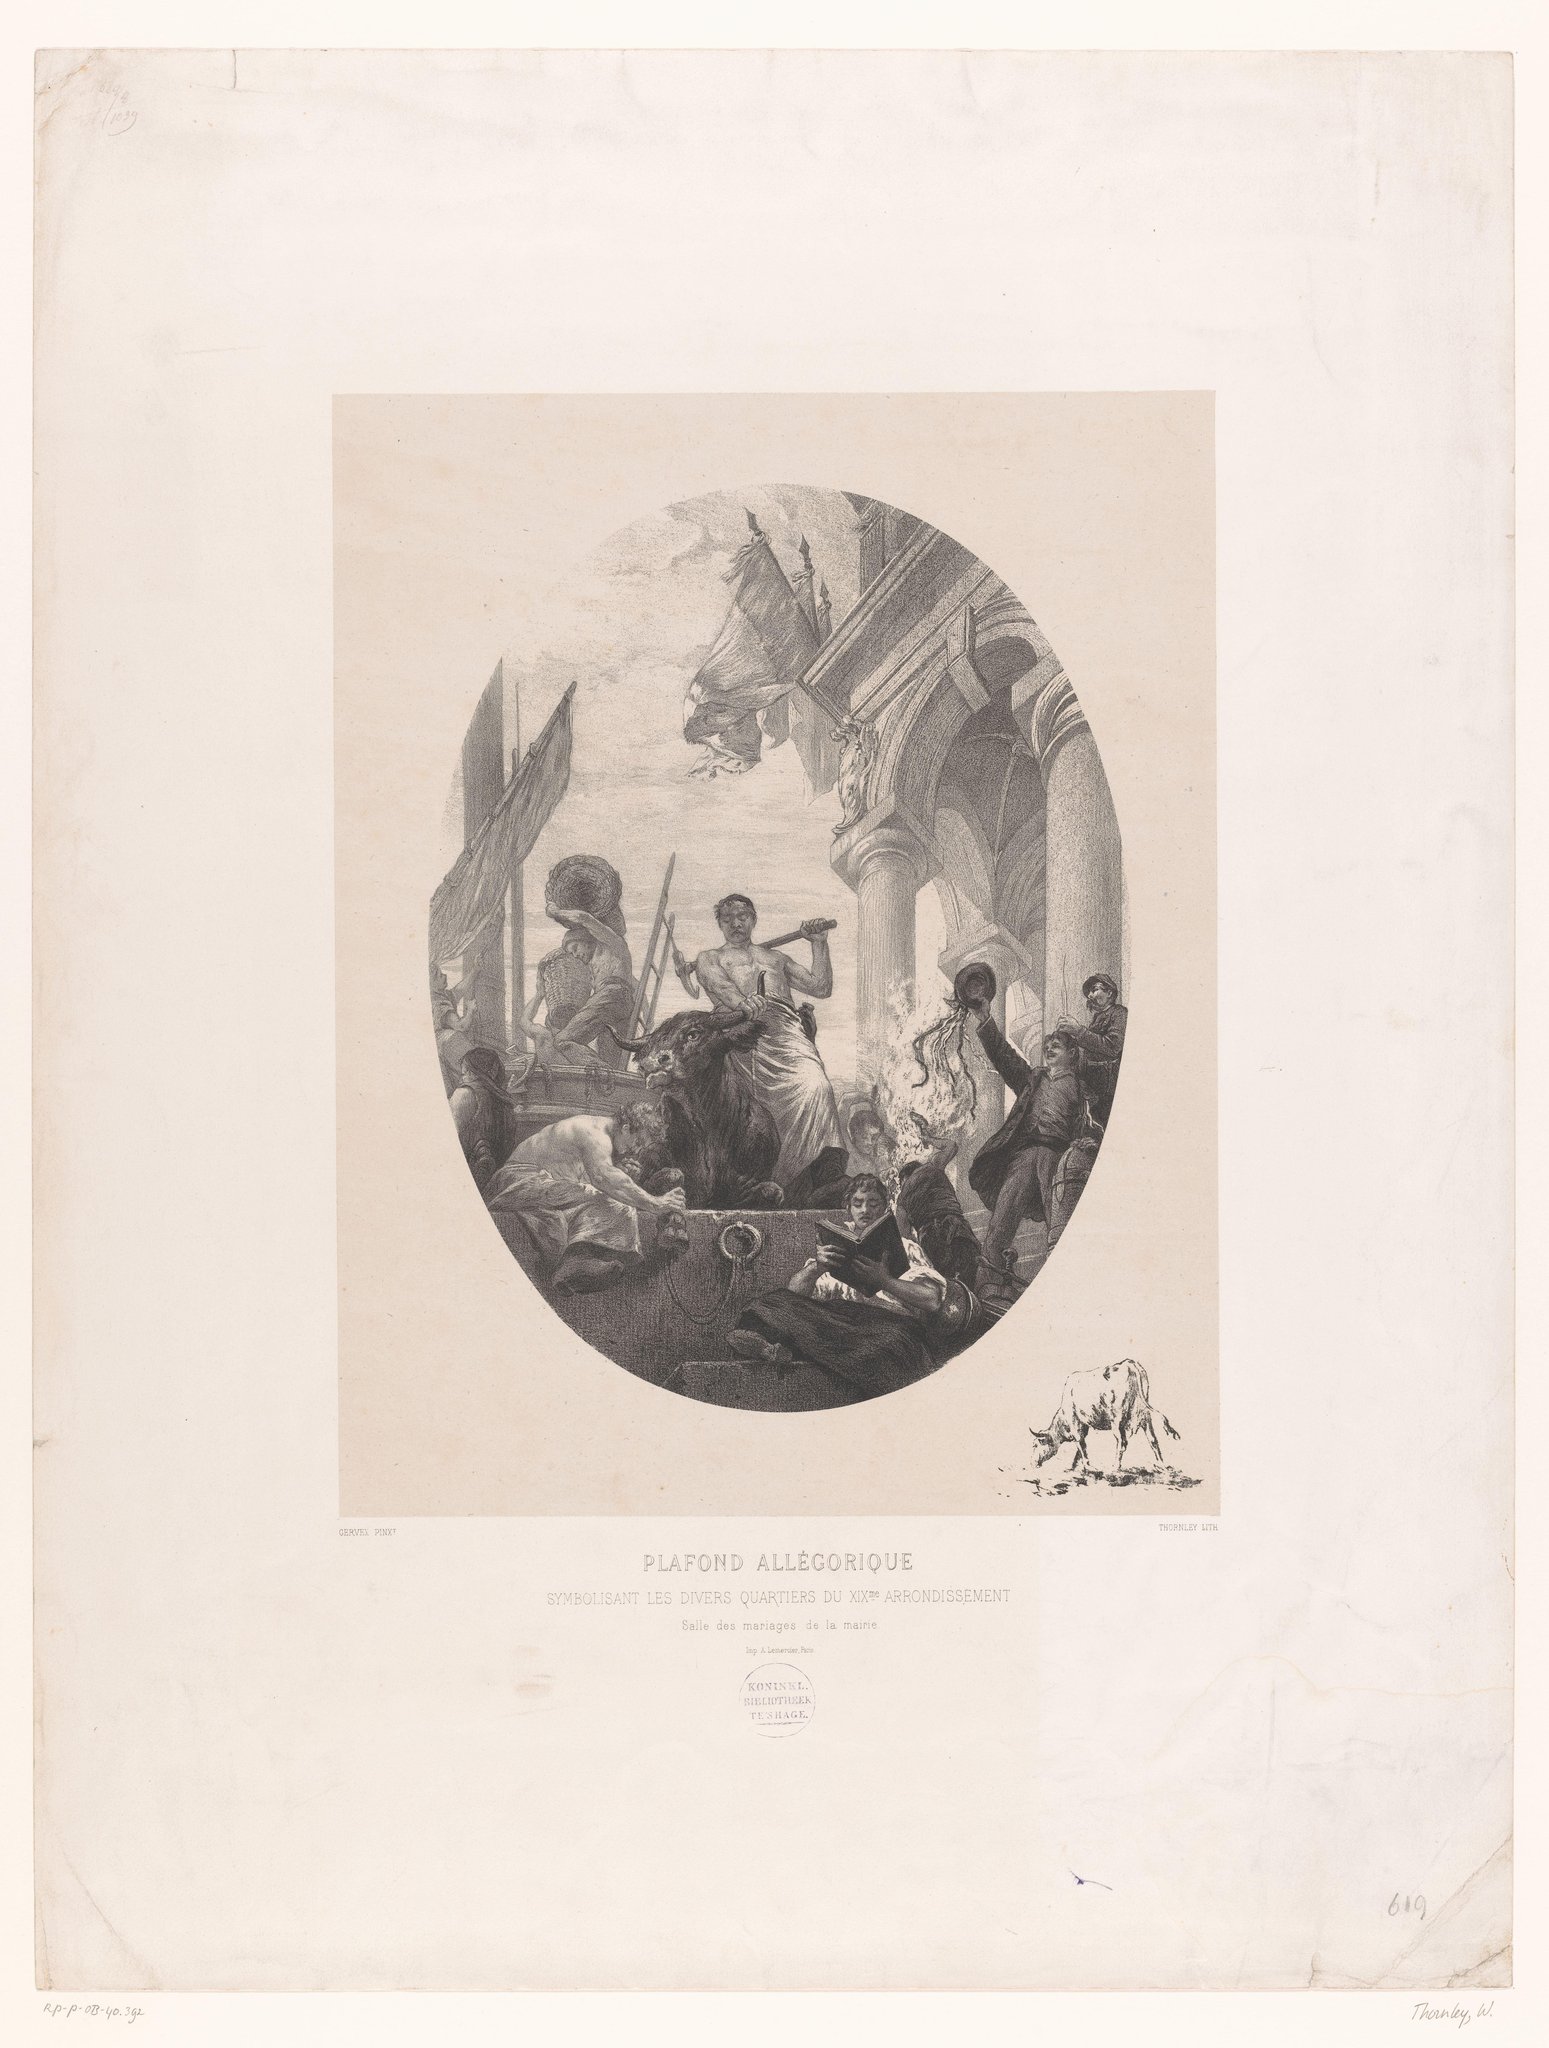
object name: print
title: Plafond allégorique, symbolisant les divers quartiers du XIXme. arrondissement, salle des mariages de la mairie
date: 1880-1892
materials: paper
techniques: lithograph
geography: paris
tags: bull, reading, boat or vehicle drawn by (fabulous) animal(s) of the sea, flag, colours (as symbol of the state, etc.) (+ nation; national), paris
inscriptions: collector's mark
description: Onder de voorstelling een remarque van een koe.